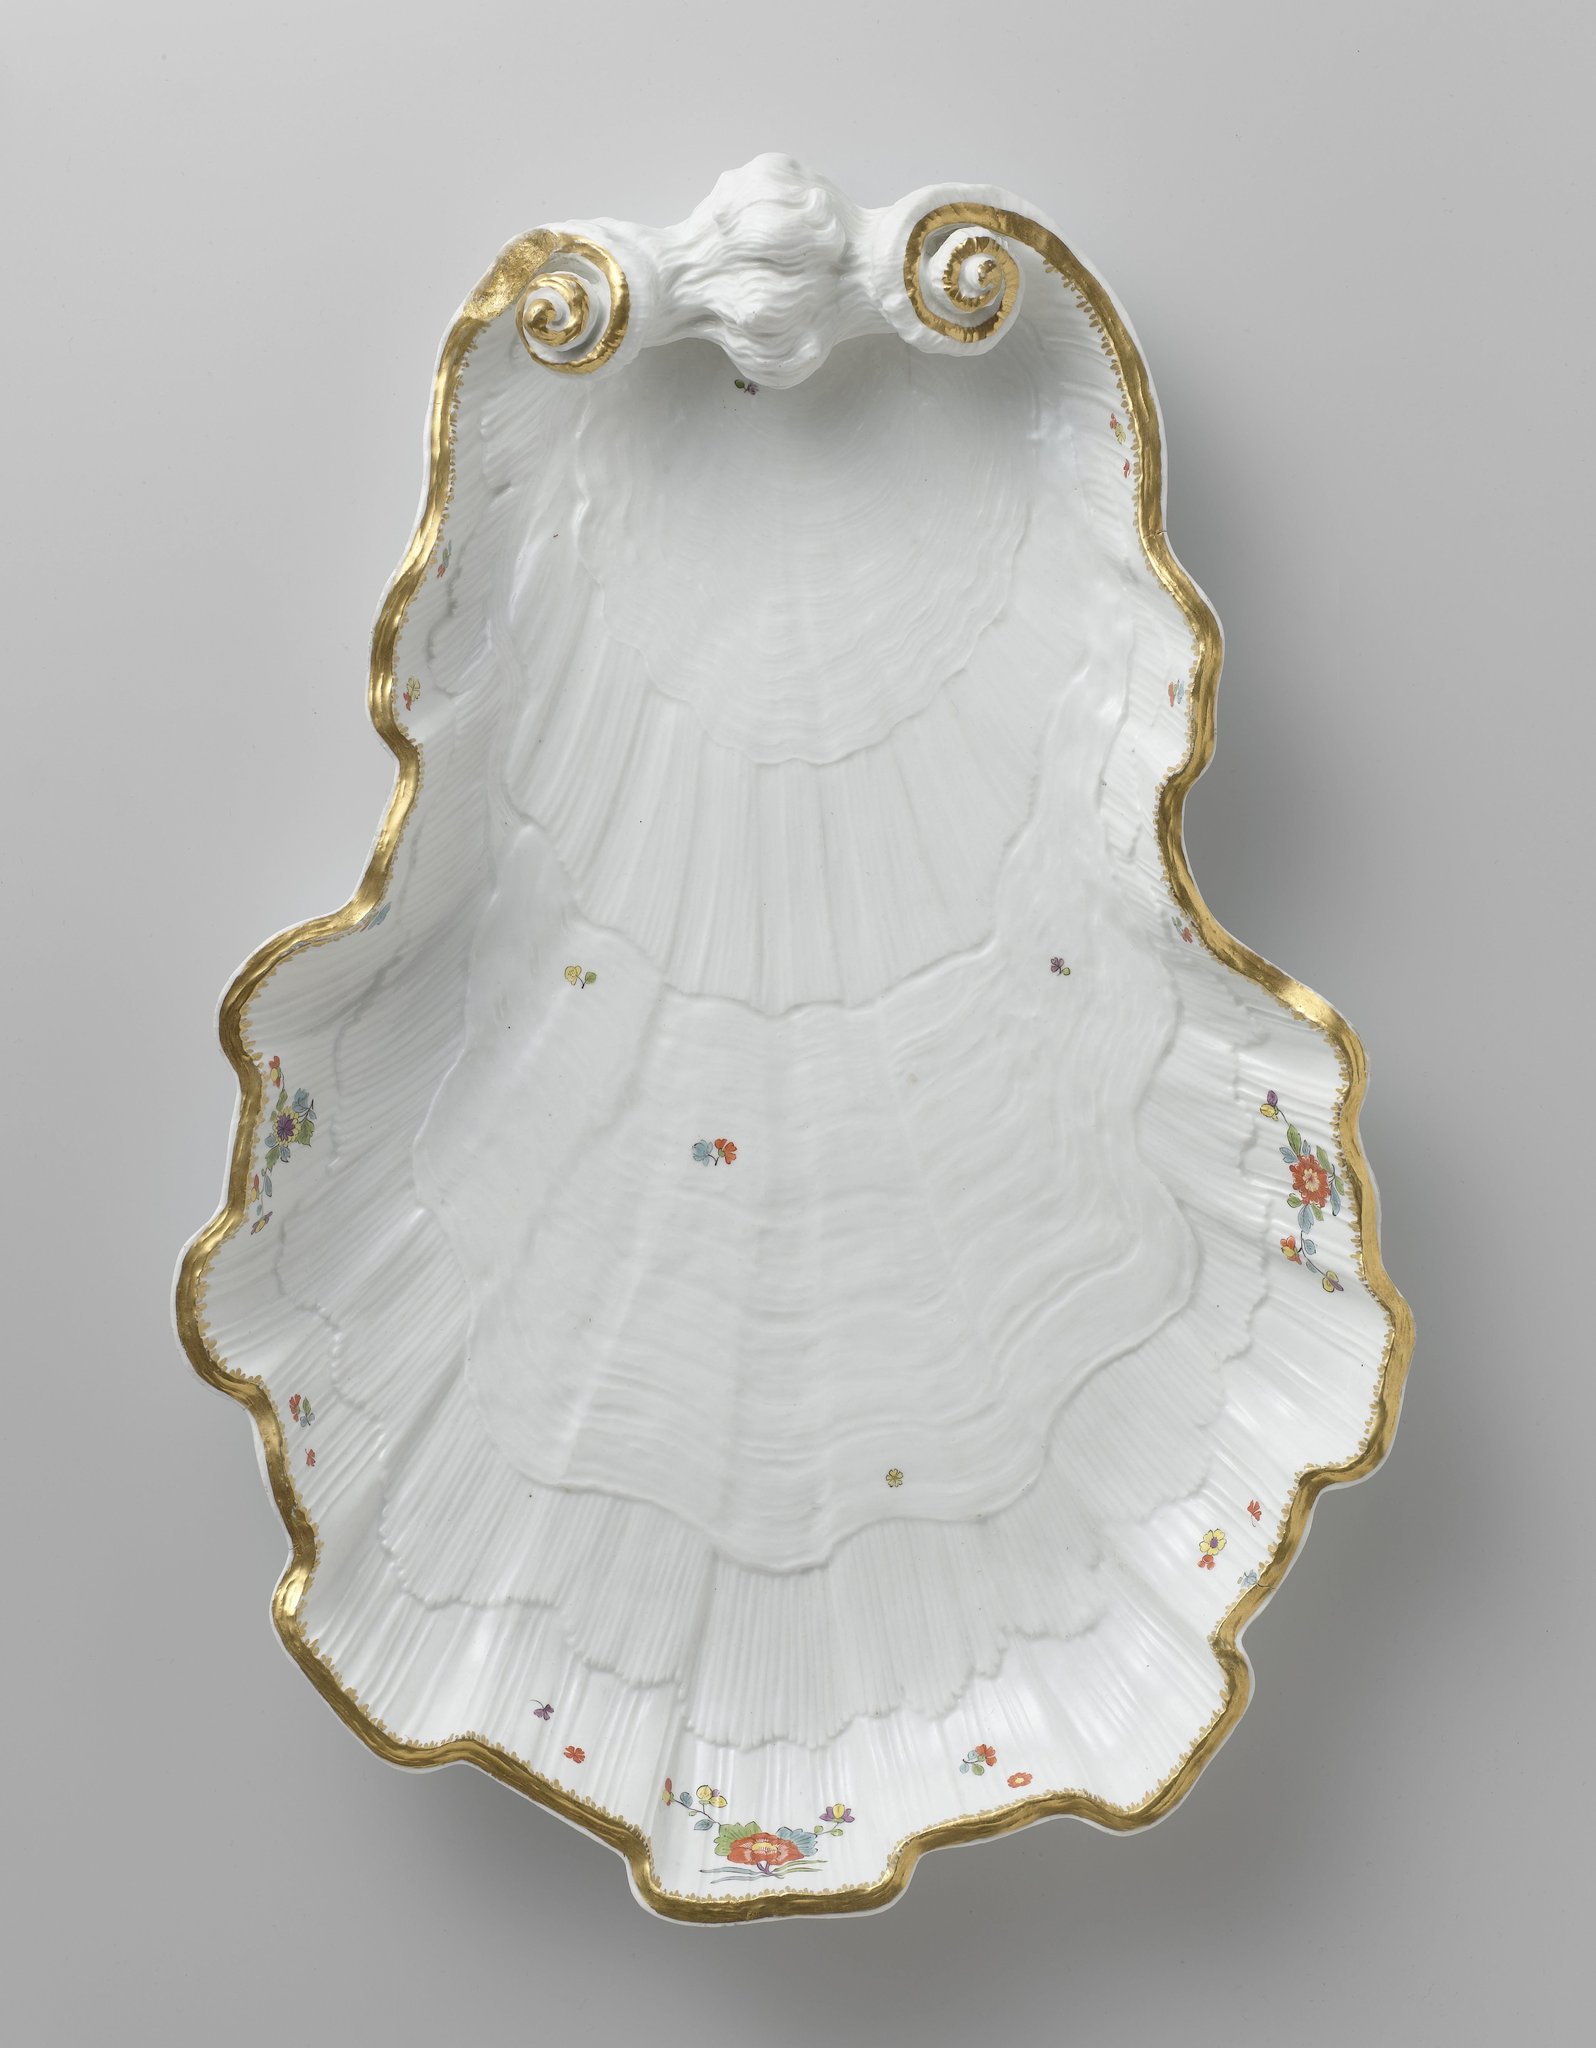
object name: eating drinking utensil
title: Parts of a Service, Known as the ‘Swan Service’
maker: johann joachim kändler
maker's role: designer, sculptor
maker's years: 1706-1775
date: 1739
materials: porcelain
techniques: painted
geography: meissen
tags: heinrich von brühl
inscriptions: factory mark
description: These pieces are part of one of the most famous services produced by the Meissen Porcelain Factory. It was ordered by Count Heinrich von Brühl, a statesman and the factory’s director. Scenes of swans occur on almost every one of the more than 2200 parts. On display are a dish, a sauceboat, and the base of the plat-de-ménage (centrepiece). The large basket decorated with figures that stood on it has been lost.